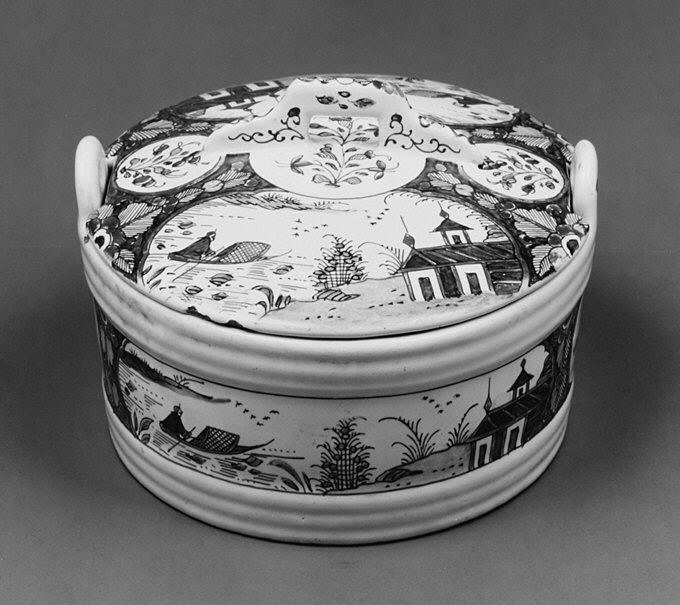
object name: butter dish with cover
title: Pair of butter dishes with covers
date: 1701-1800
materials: earthenware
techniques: glazing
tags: houses,boats